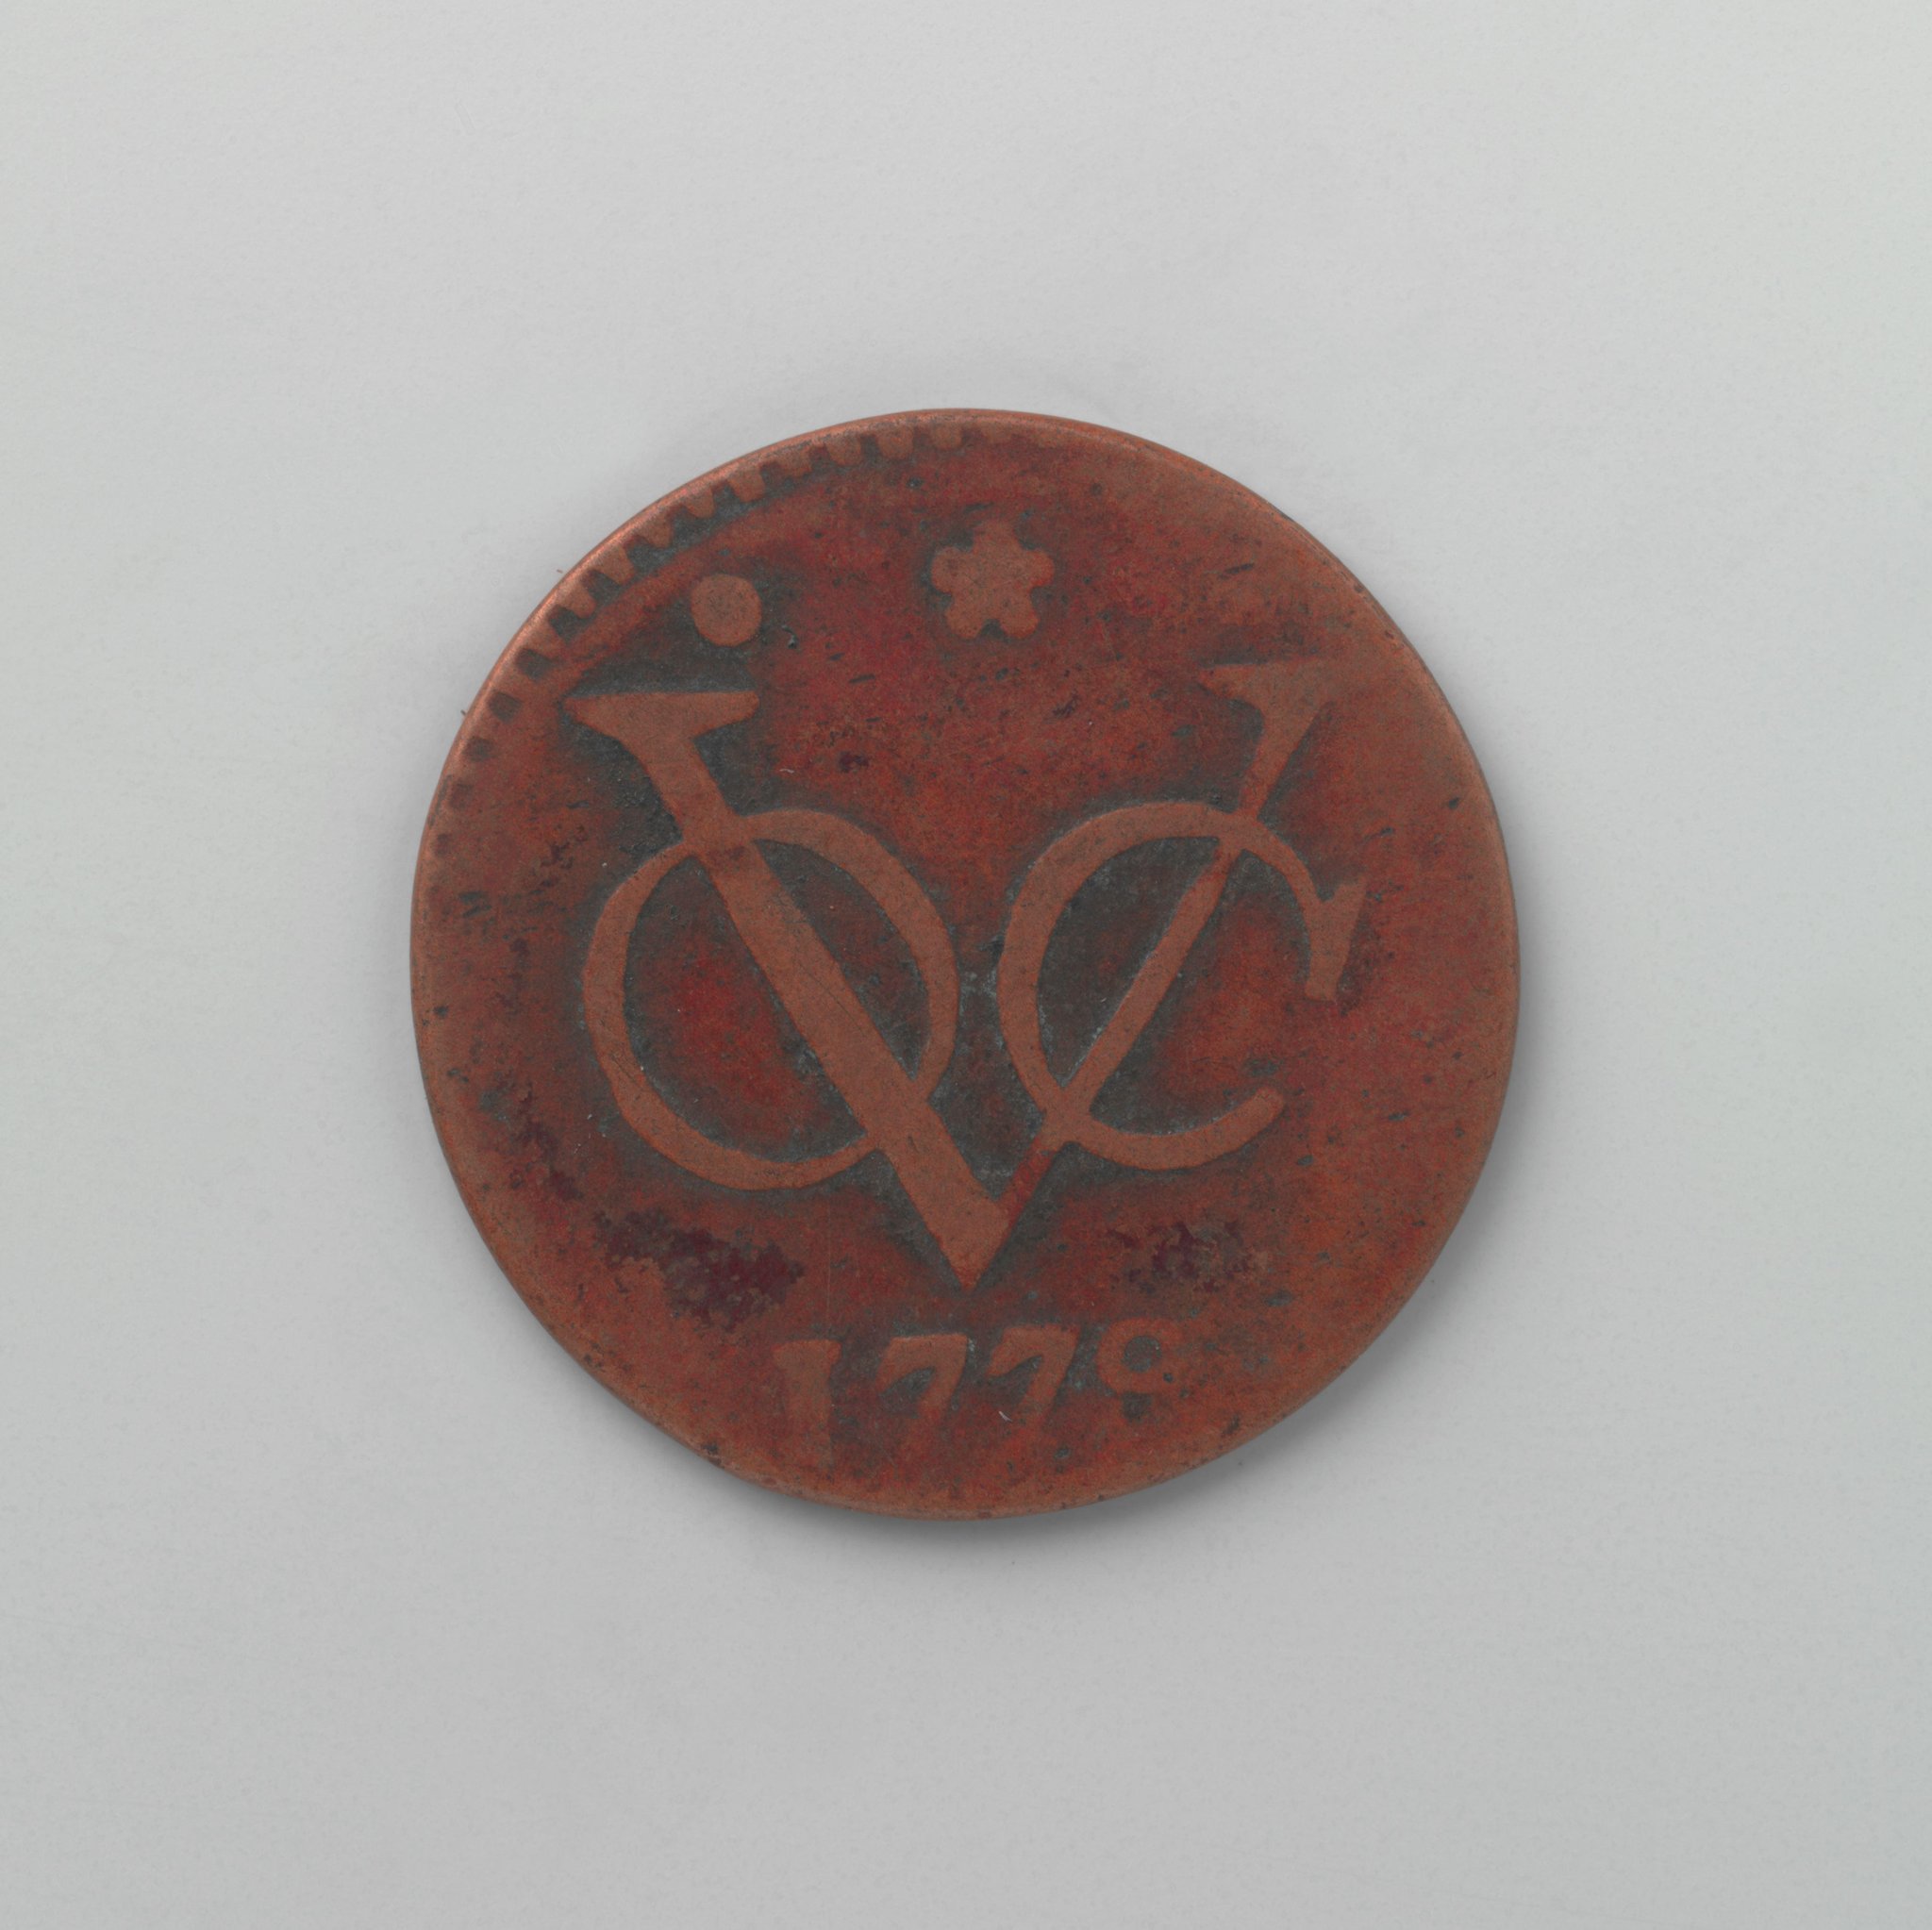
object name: coin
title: Duit van de VOC uit Westfriesland,1778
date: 1778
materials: copper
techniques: striking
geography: medemblik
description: Koperen munt. Voorzijde: gekroond wapenschild van Westfriesland. Keerzijde: monogram van de VOC, waarboven muntteken en waaronder jaartal. Gladde rand.